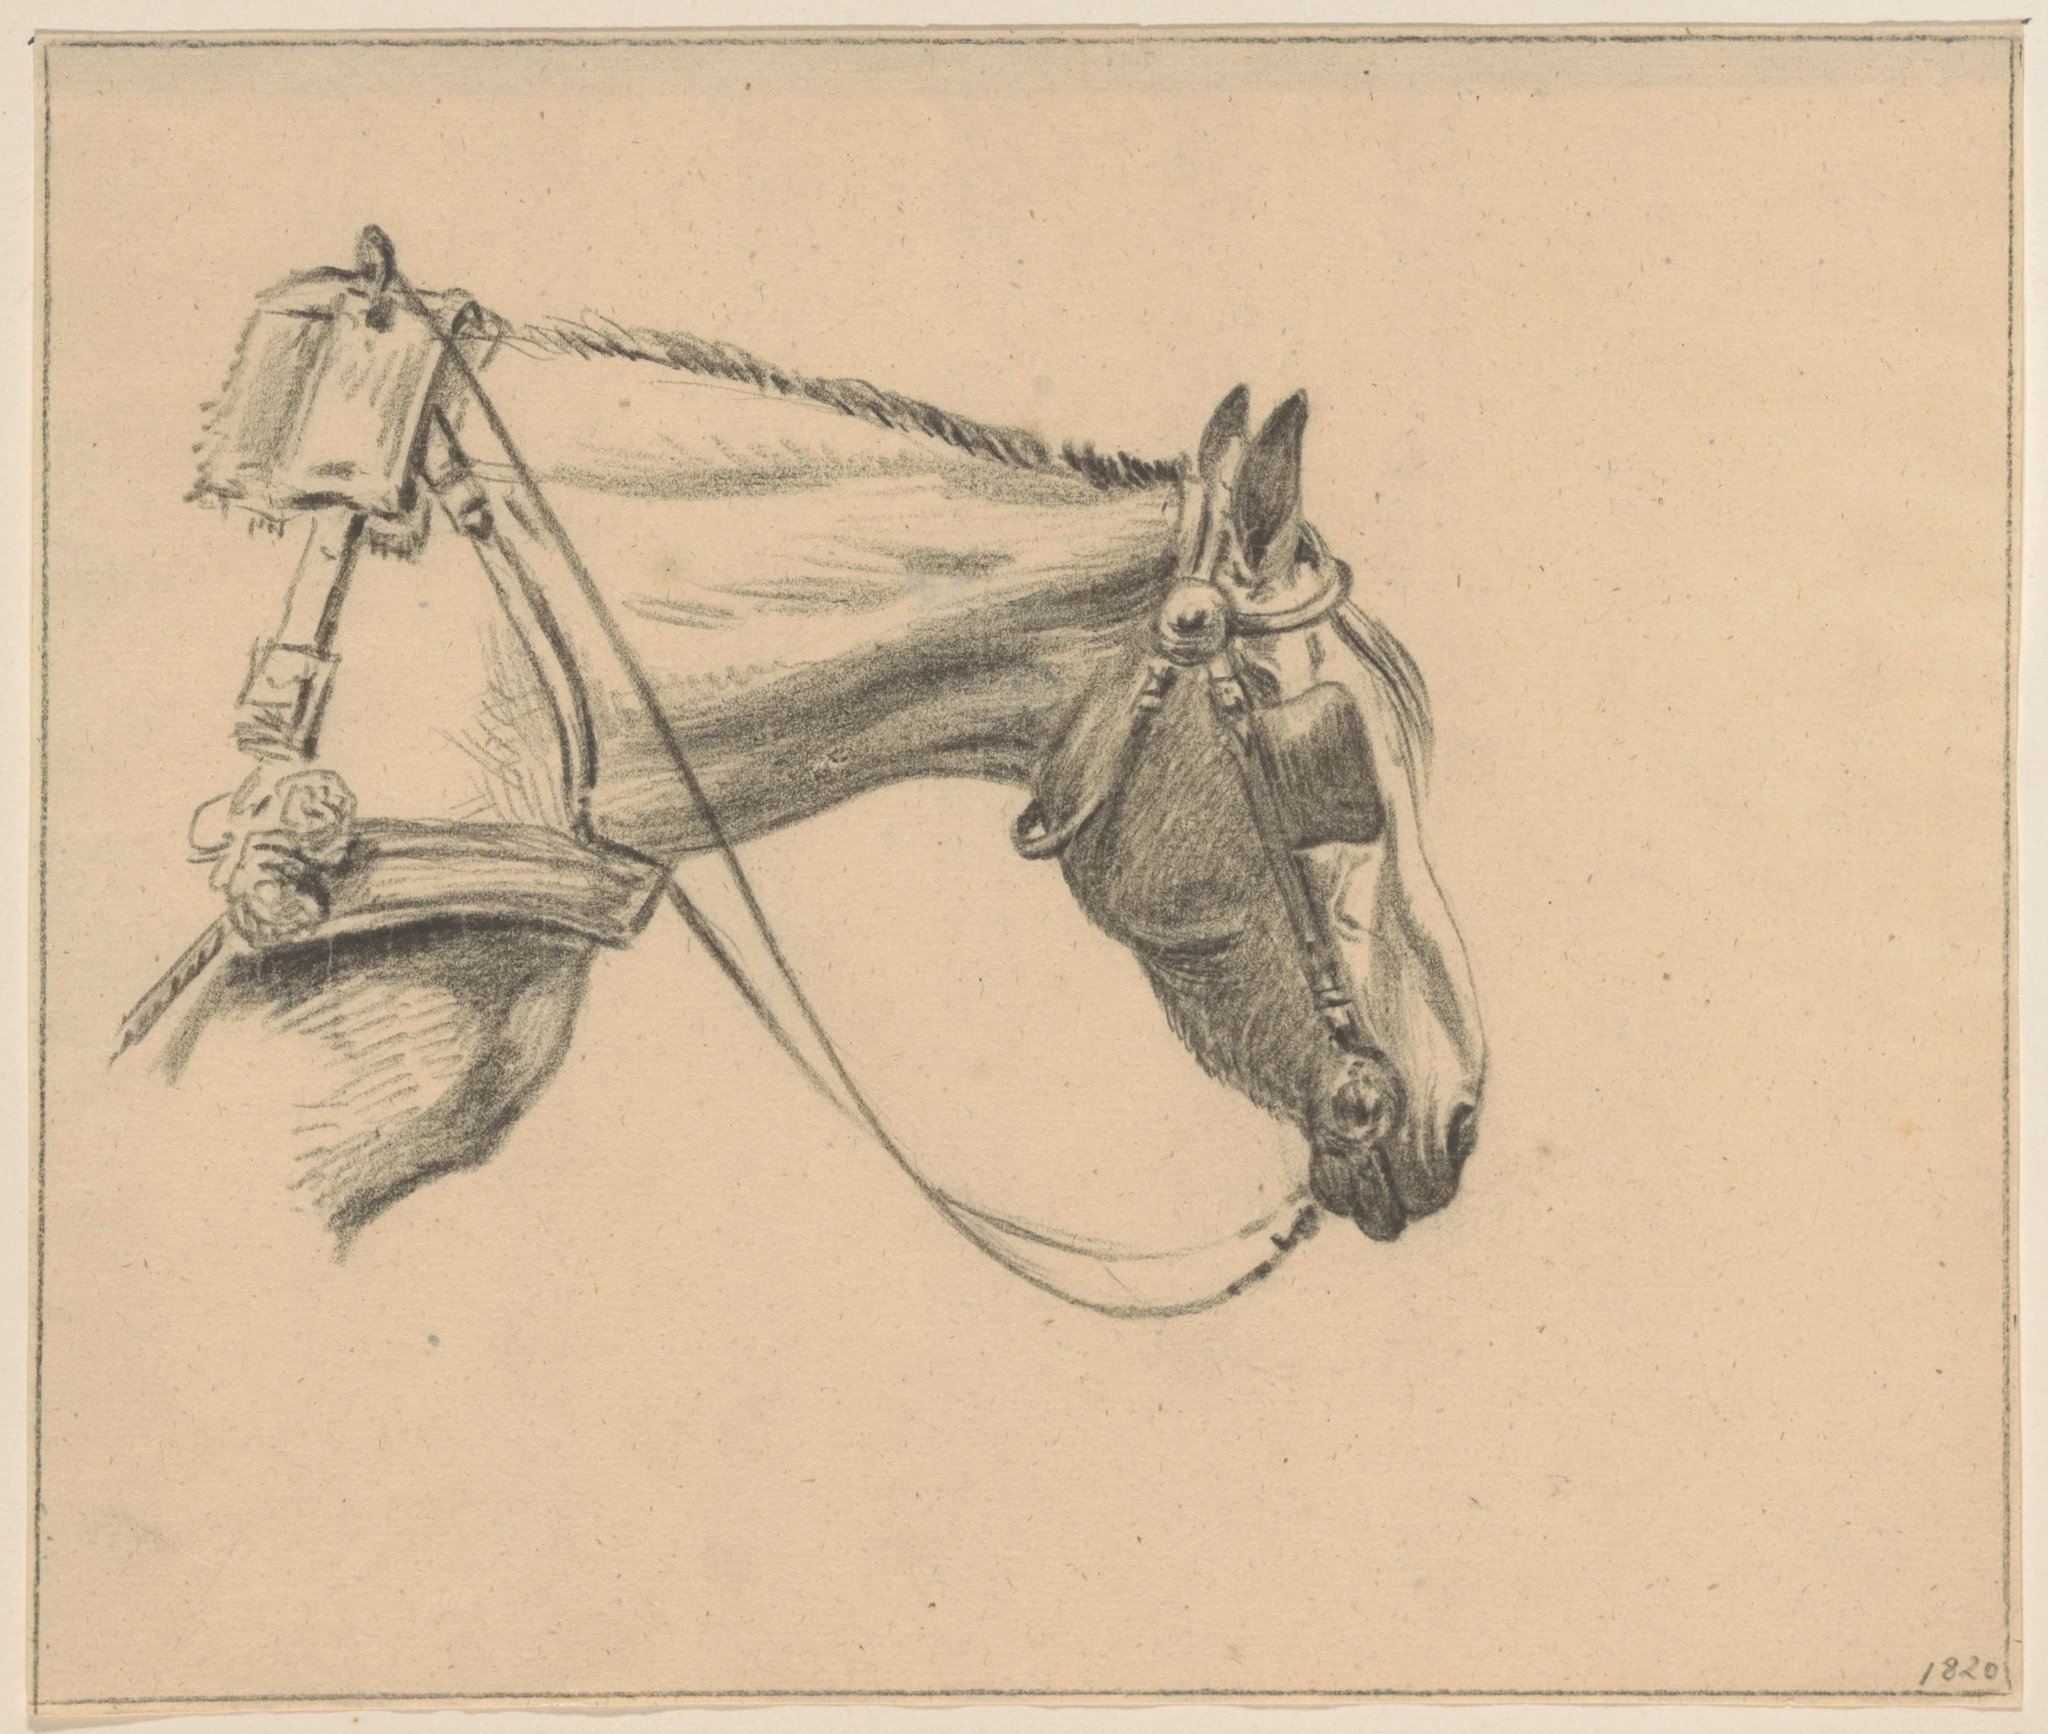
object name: drawing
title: Hoofd van een paard met oogkleppen op, naar rechts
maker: jean bernard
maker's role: draughtsman, print maker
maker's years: 1765-1833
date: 1820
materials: chalk, paper, pencil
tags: horse